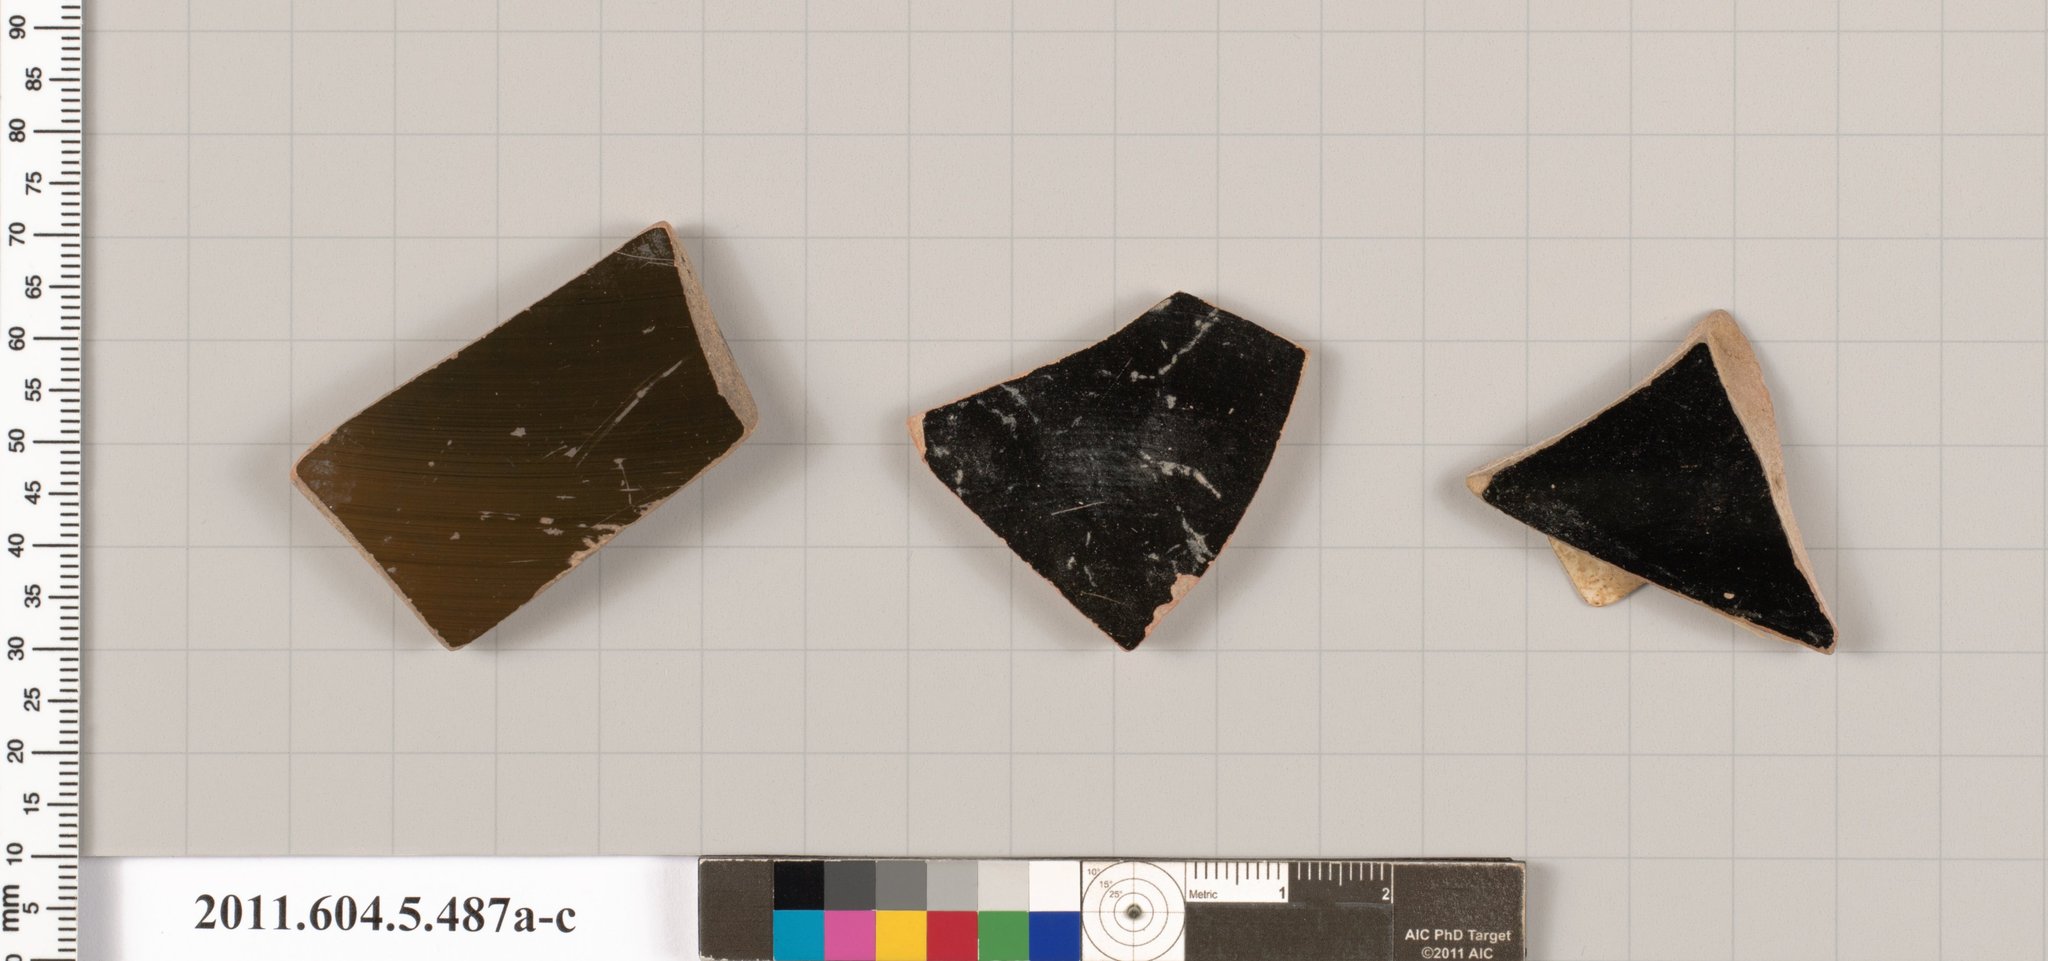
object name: kylix fragment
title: Terracotta fragments of kylikes (drinking cups)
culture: greek, attic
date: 600-401 BCE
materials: terracotta